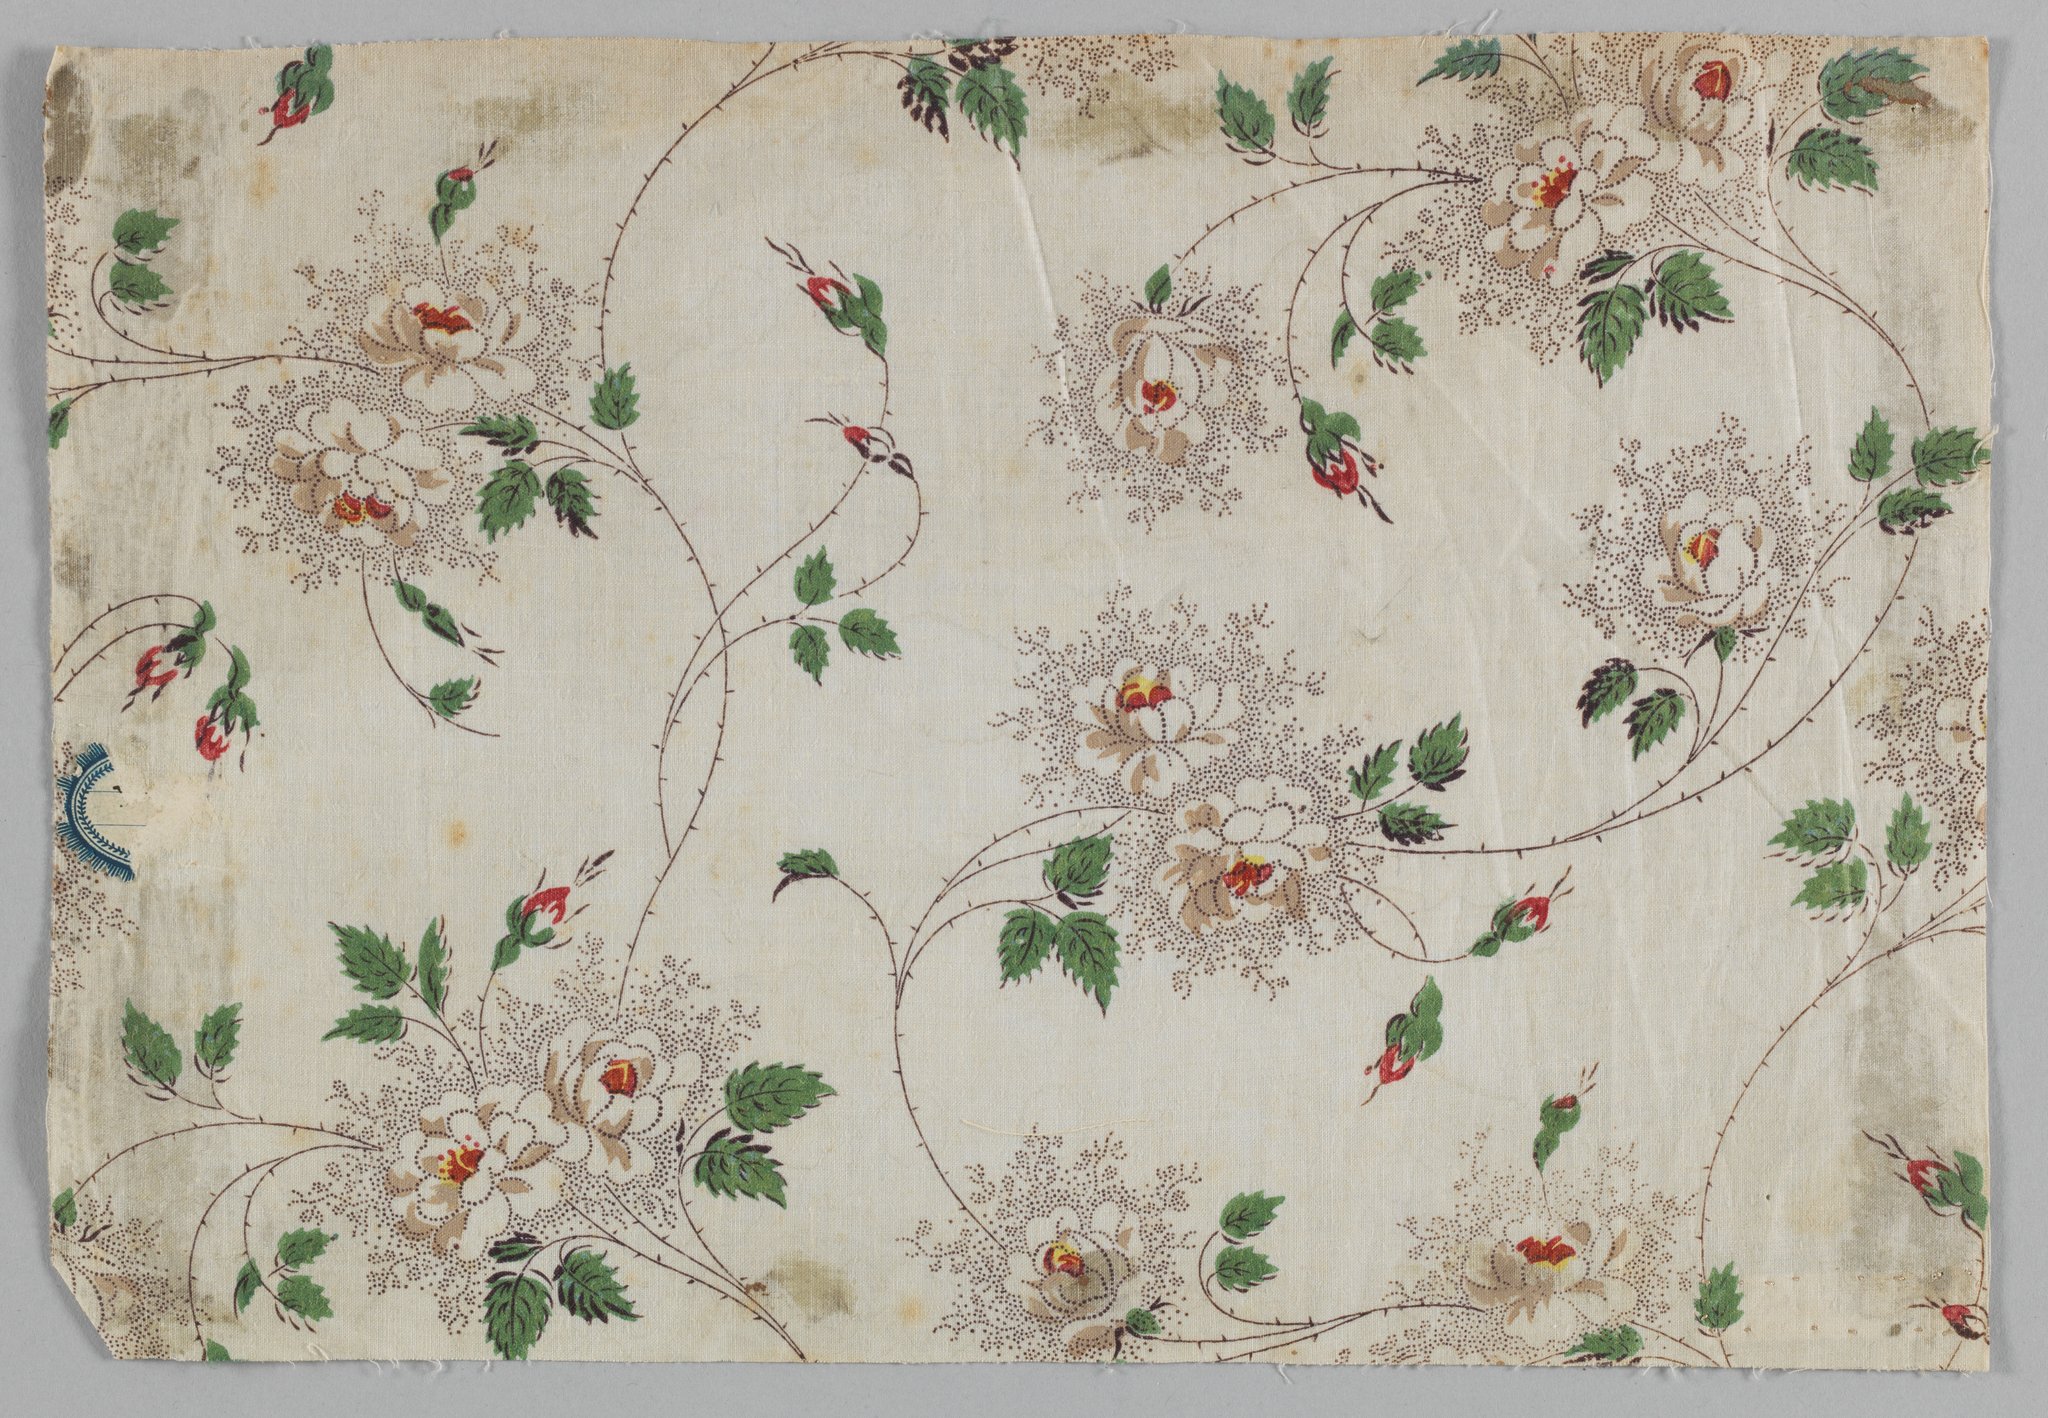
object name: piece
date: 1801-1900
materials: cotton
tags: flowers